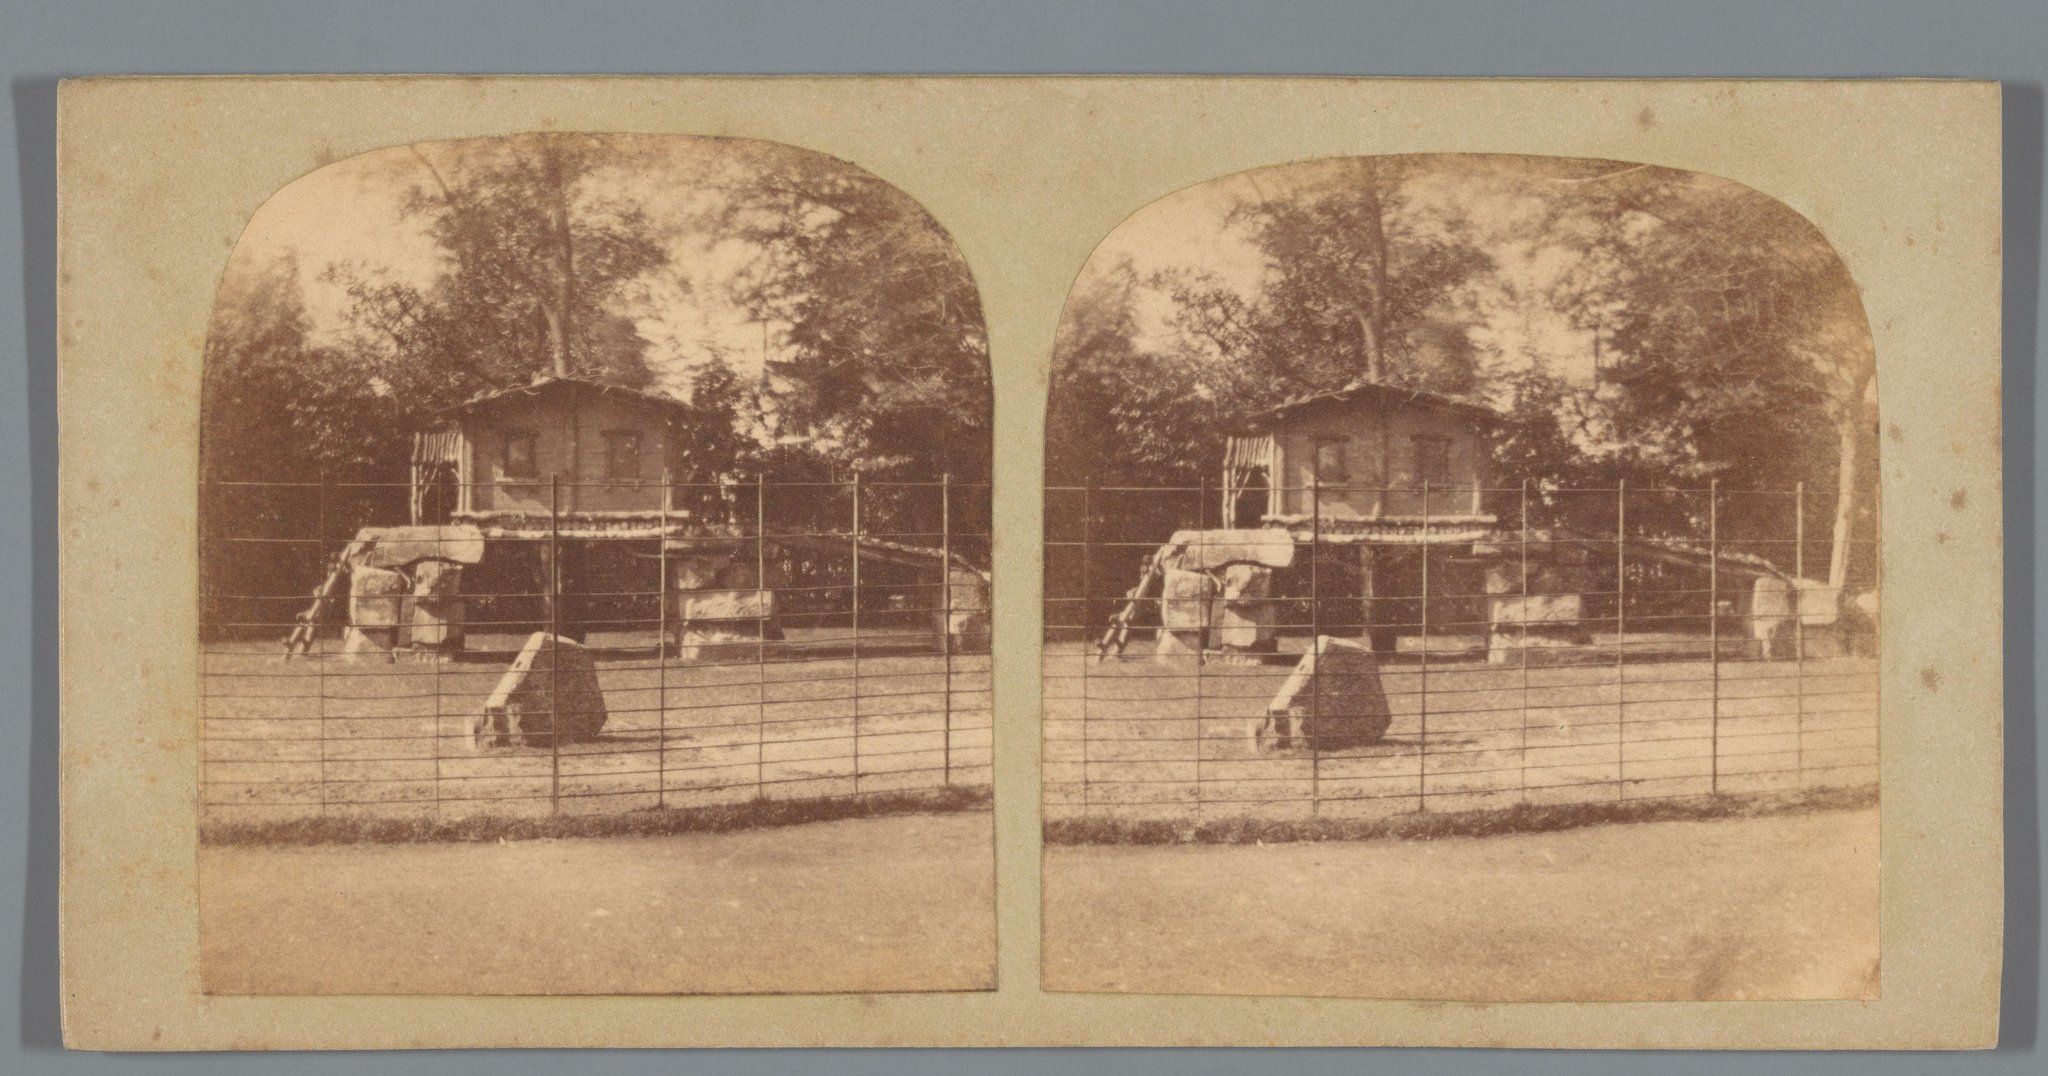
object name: stereograph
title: Dierenverblijf in Artis, Amsterdam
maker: Anonymous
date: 1857-1863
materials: cardboard, paper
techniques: albumen print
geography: amsterdam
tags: zoological garden, zoo, seen as place where non-domestic animals are kept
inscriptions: inscription: ‘Natura Artis Magistra [...]’